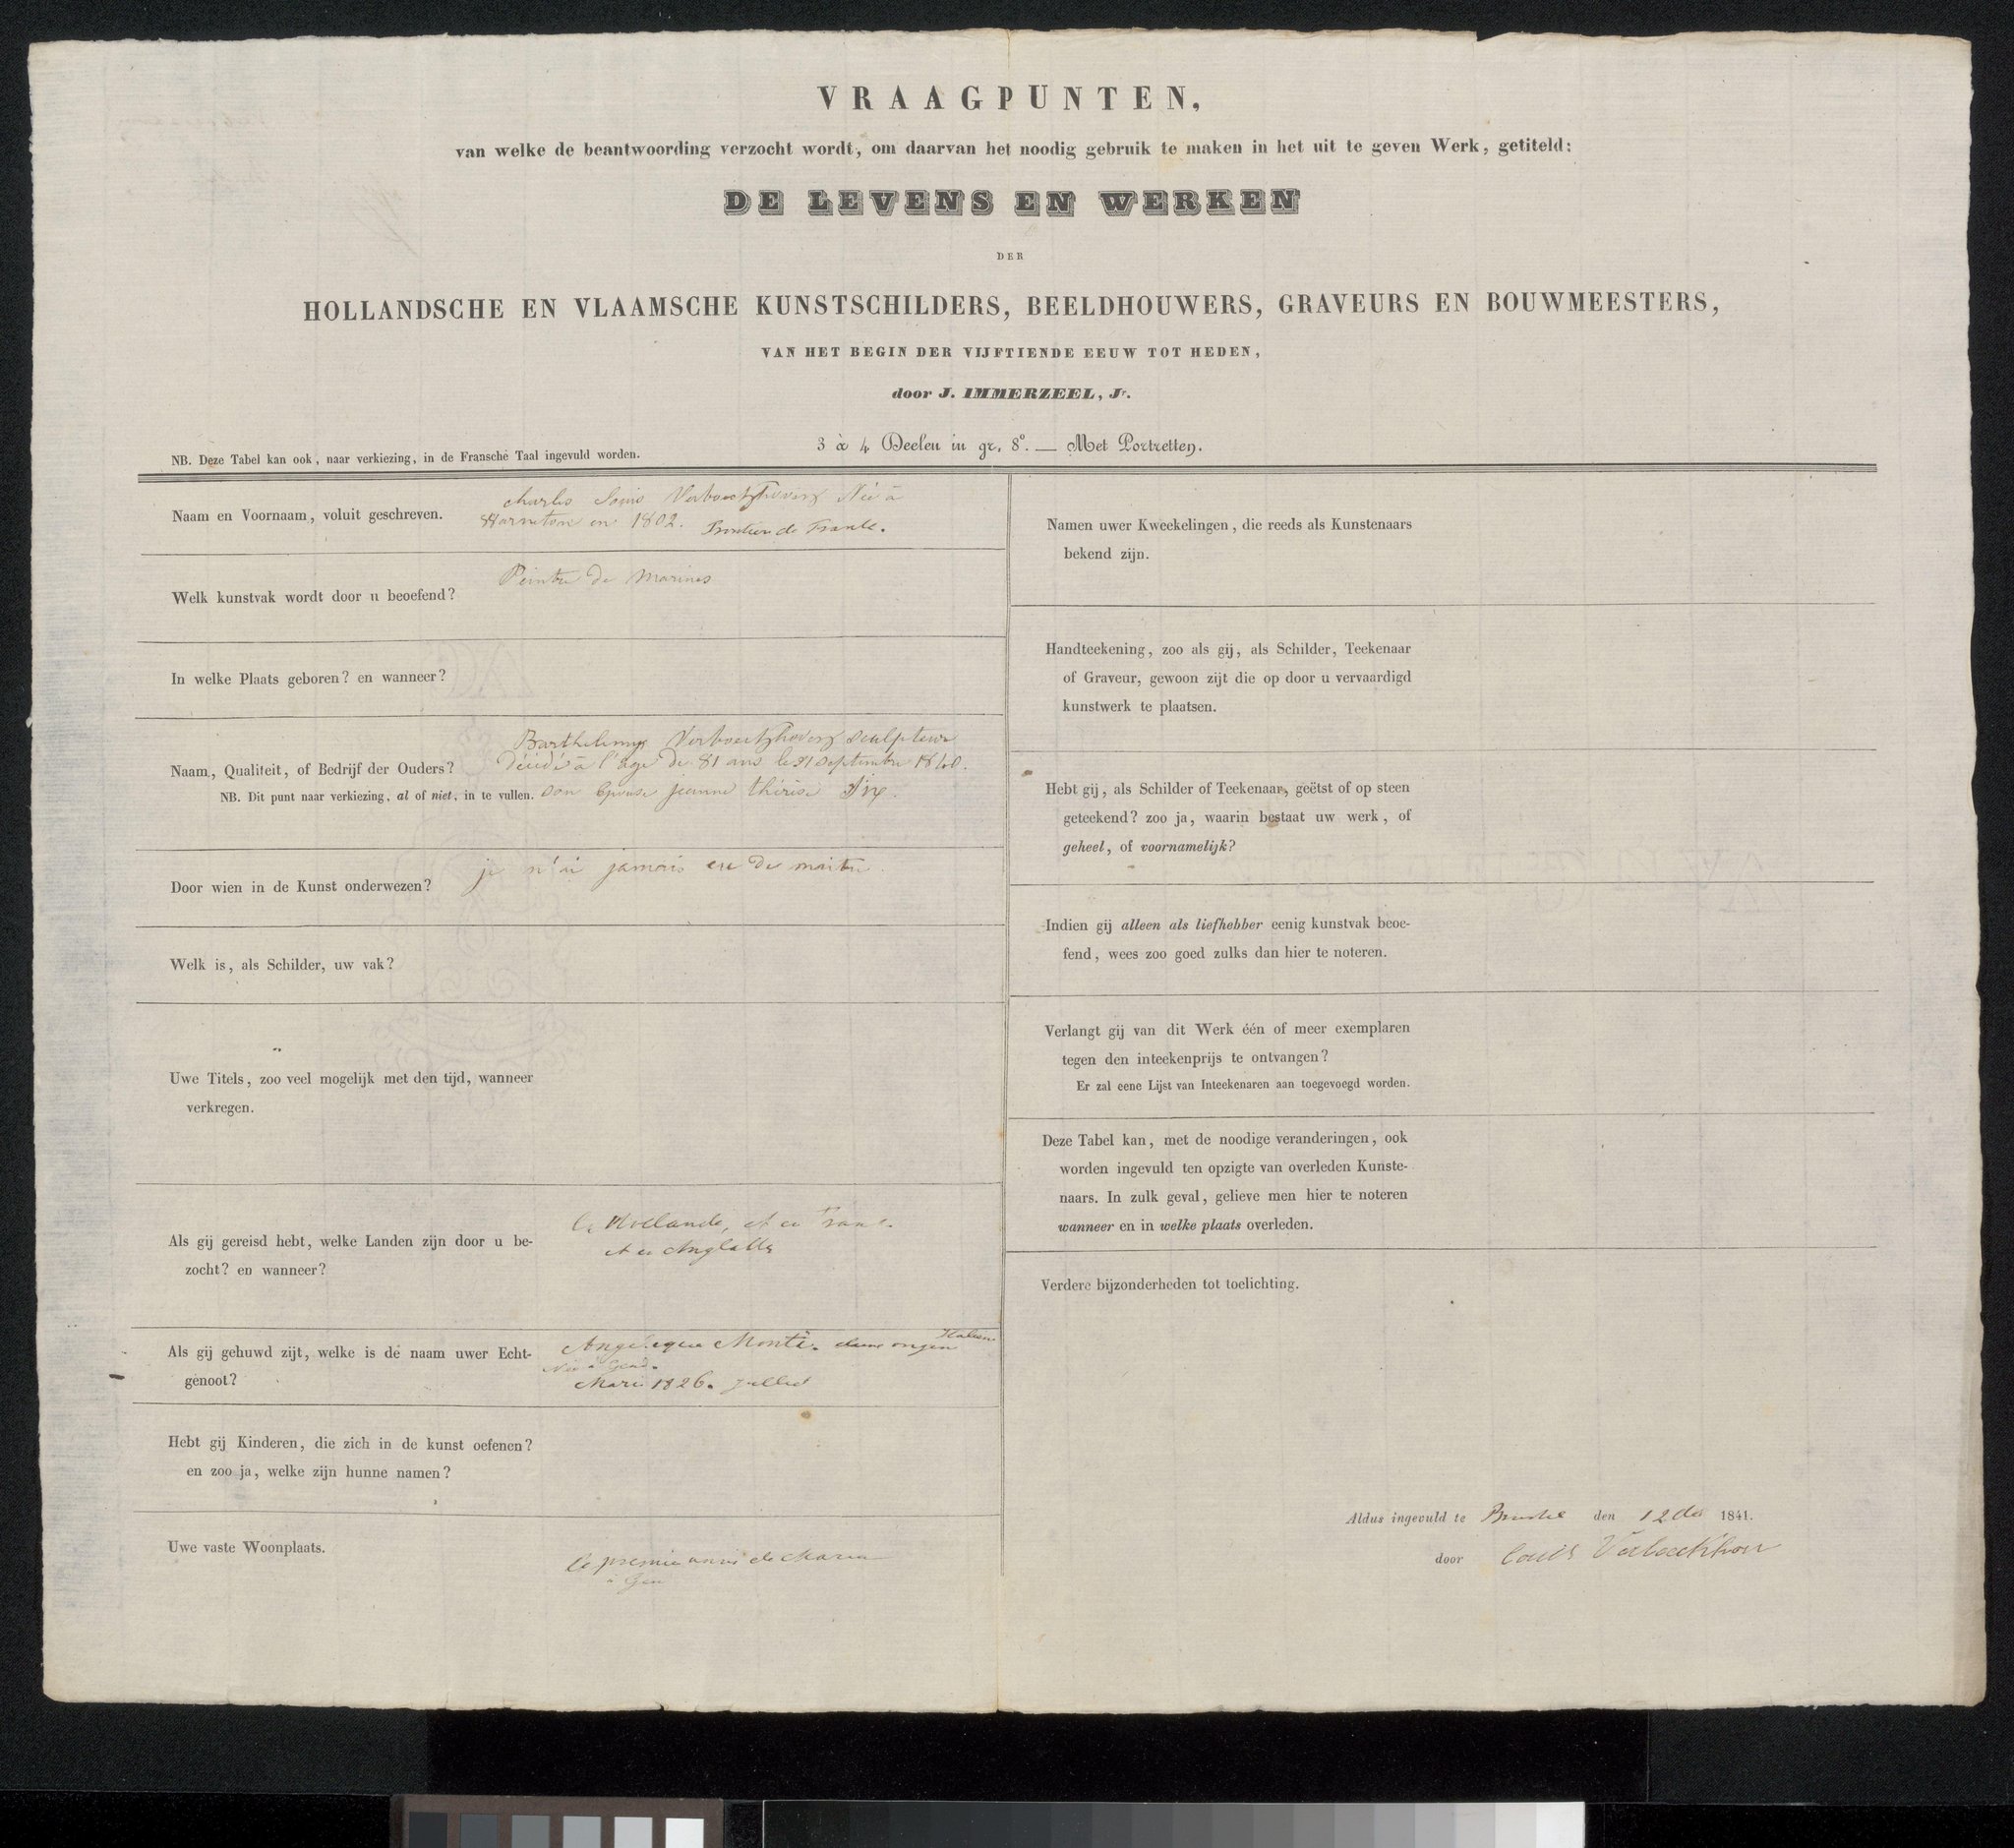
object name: questionnaire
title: Enquêteformulier ingevuld door Charles Louis Verboeckhoven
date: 1841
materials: ink, paper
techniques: pen, printing, writing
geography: brussels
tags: brussels, draughtsman, charles louis verboeckhoven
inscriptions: watermark, inscription: ‘Vraagpunten,/ van welke de beantwoording verzocht wordt, om daarvan het noodig gebruik te maken in het uit te geven Werk, getiteld: De levens en werken/ der Hollandsche en Vlaamsche kunstschilders, beeldhouwers,/ graveurs en bouwmeesters, van het begin der vijftiende eeuw tot heden/ door J. Immerzeel, Jr.’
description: Opgenomen in: Immerzeel, J. Jr., De levens en werken der Hollandsche en Vlaamsche kunstschilders, beeldhouwers, graveurs en bouwmeesters, van het begin der vijftiende eeuw tot heden, Amsterdam: J.C. van Kesteren, 1842-1843.